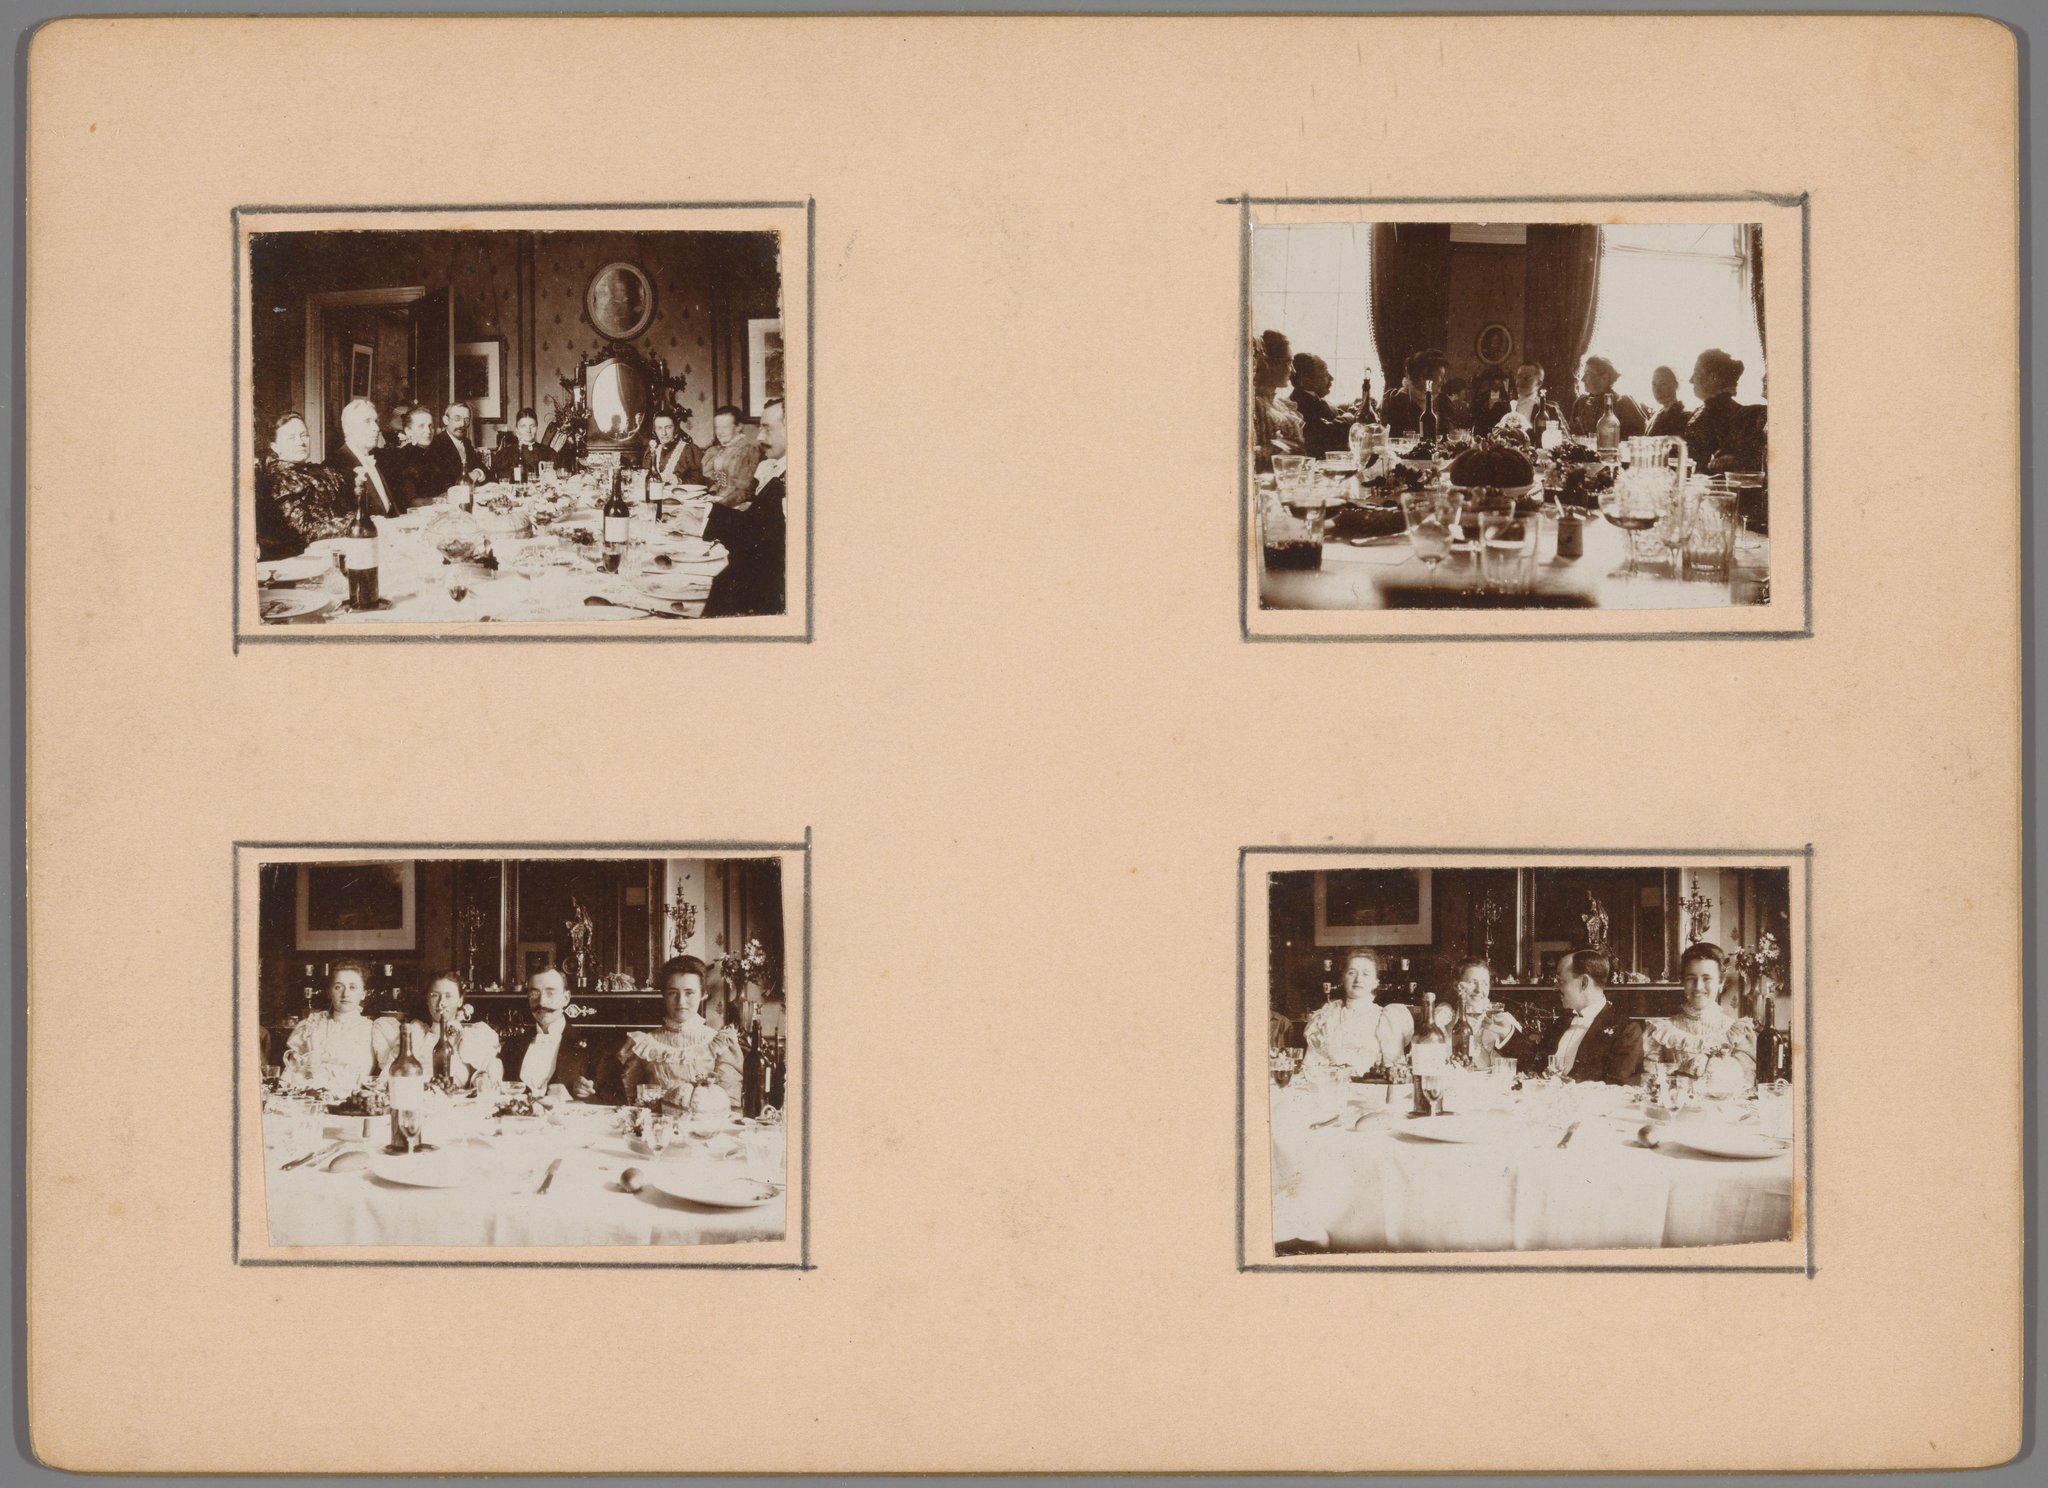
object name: photograph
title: Trouwdiner, reportage in vier kleine foto's, vermoedelijk in Nederland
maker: Anonymous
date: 1880-1910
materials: paper, cardboard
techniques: gelatin silver print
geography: netherlands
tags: wedding feast, wedding meal